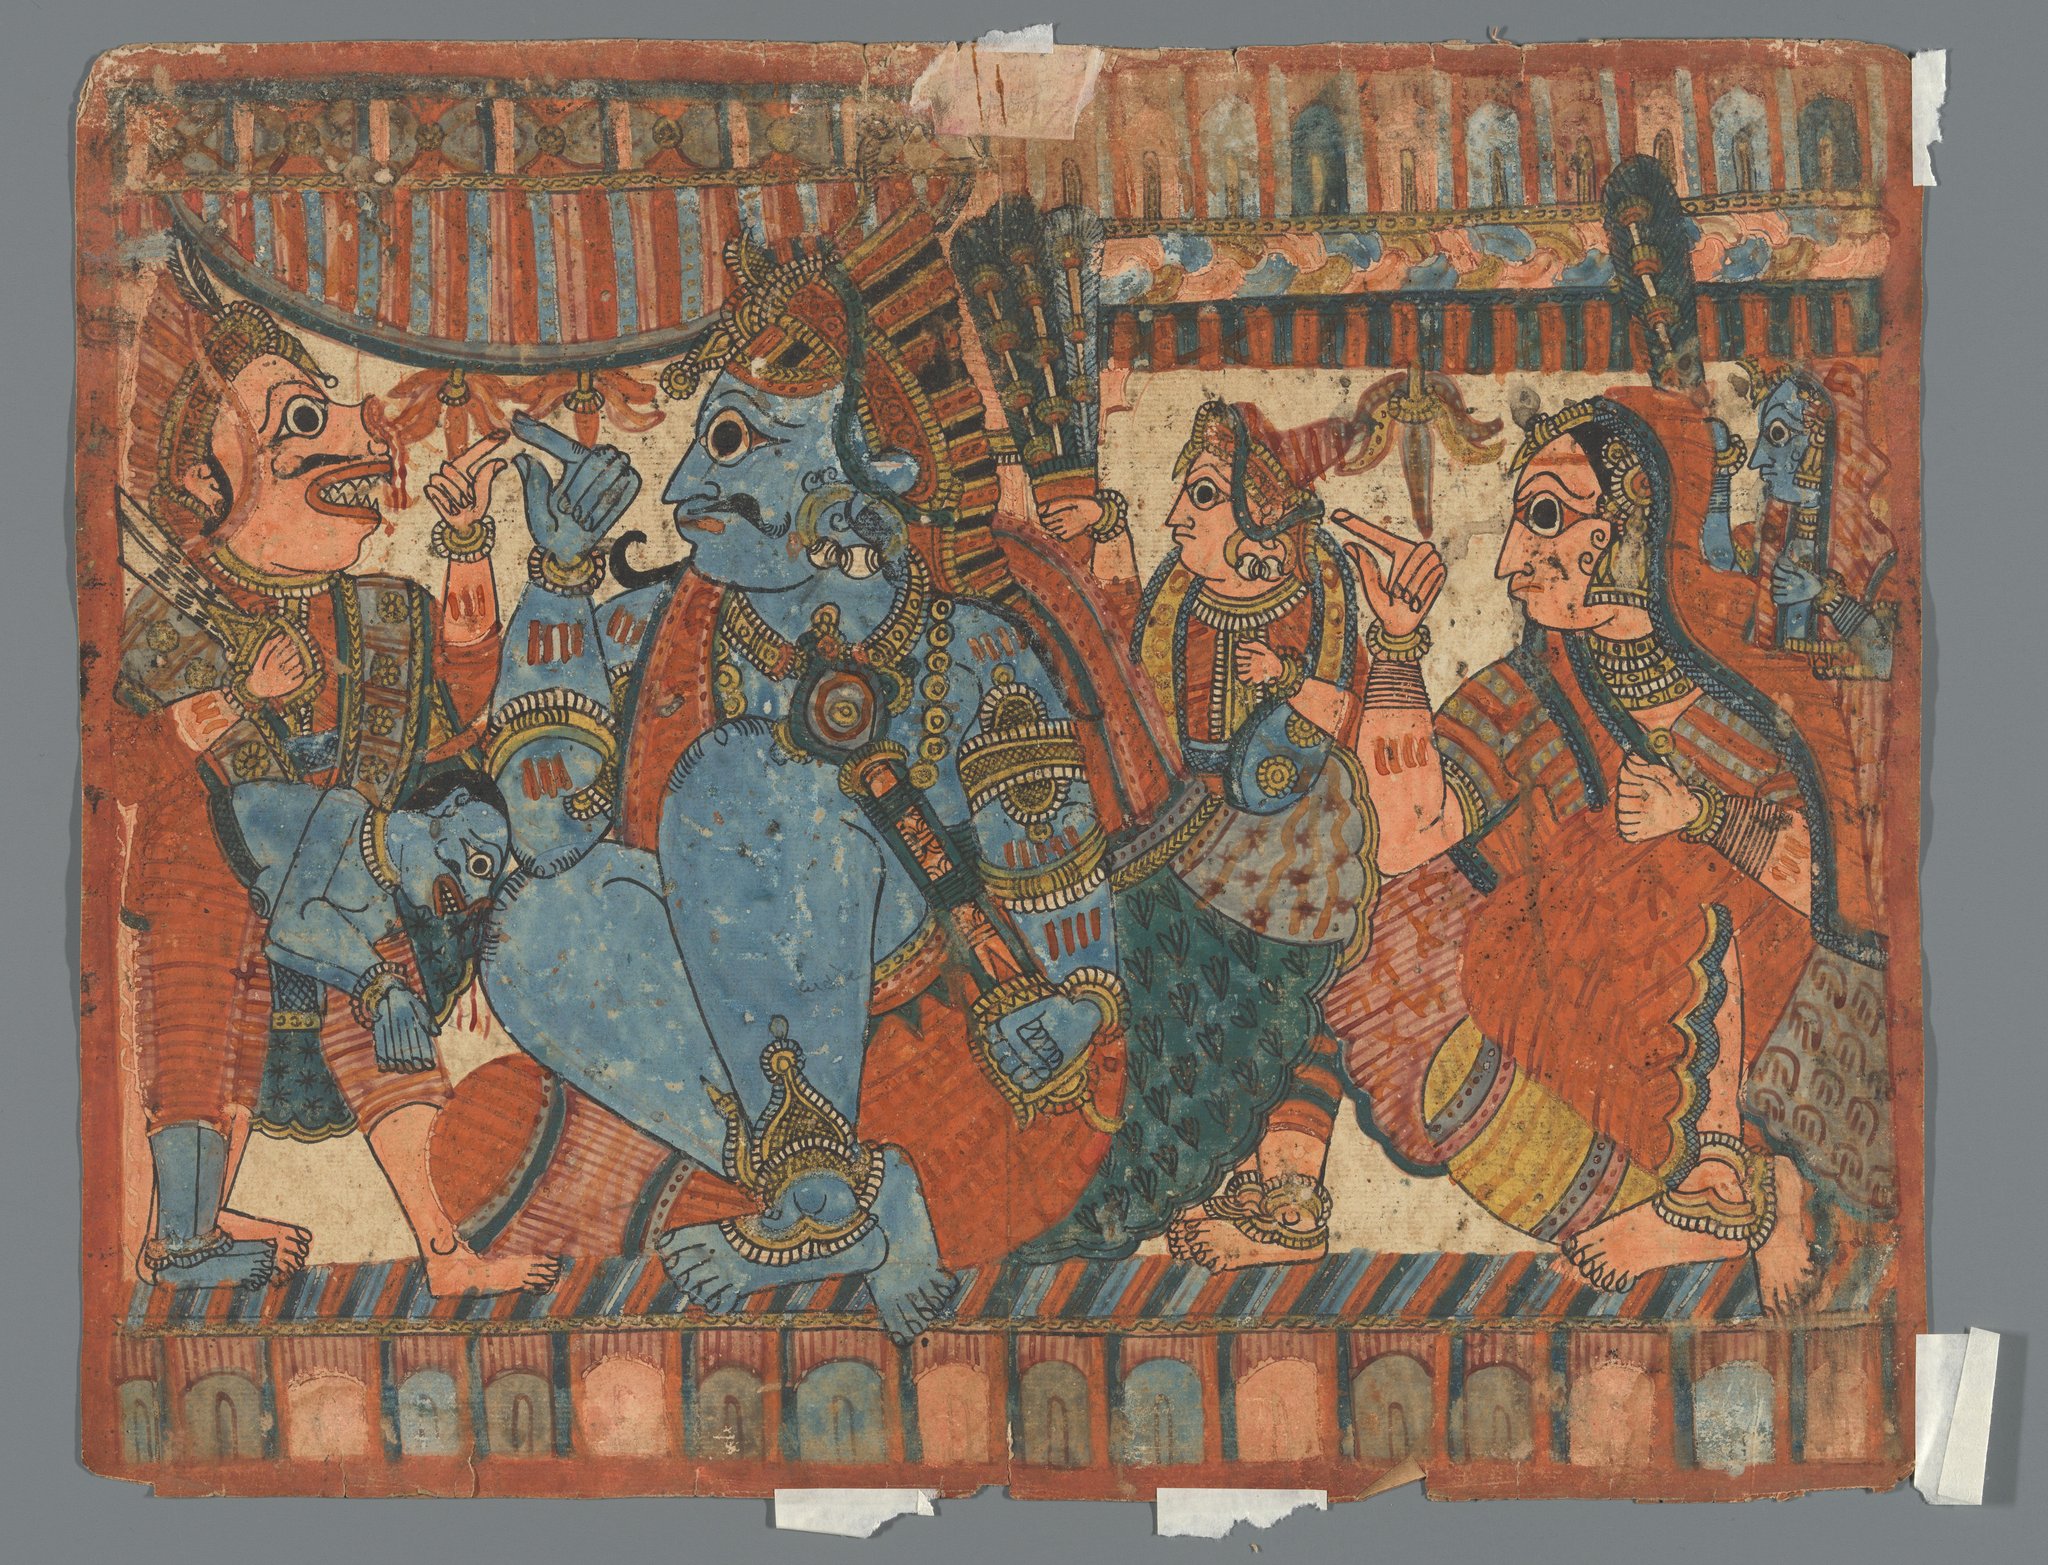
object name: indian miniature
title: ‘Paithan’ (Chitrakathi) narrative painting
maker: Anonymous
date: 1800-1899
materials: paper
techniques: brush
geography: andhra pradesh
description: The demon Ghatotkacha, son of the Mahabharata-hero Bhima, sits in a palace. He is accompanied by two female figures, one of them is possibly his mother Hidimba. Opposite him two envoys point to their cut-off noses. The scene belongs to a set illustrating the marriage of Abhimanyu and Vatsala.